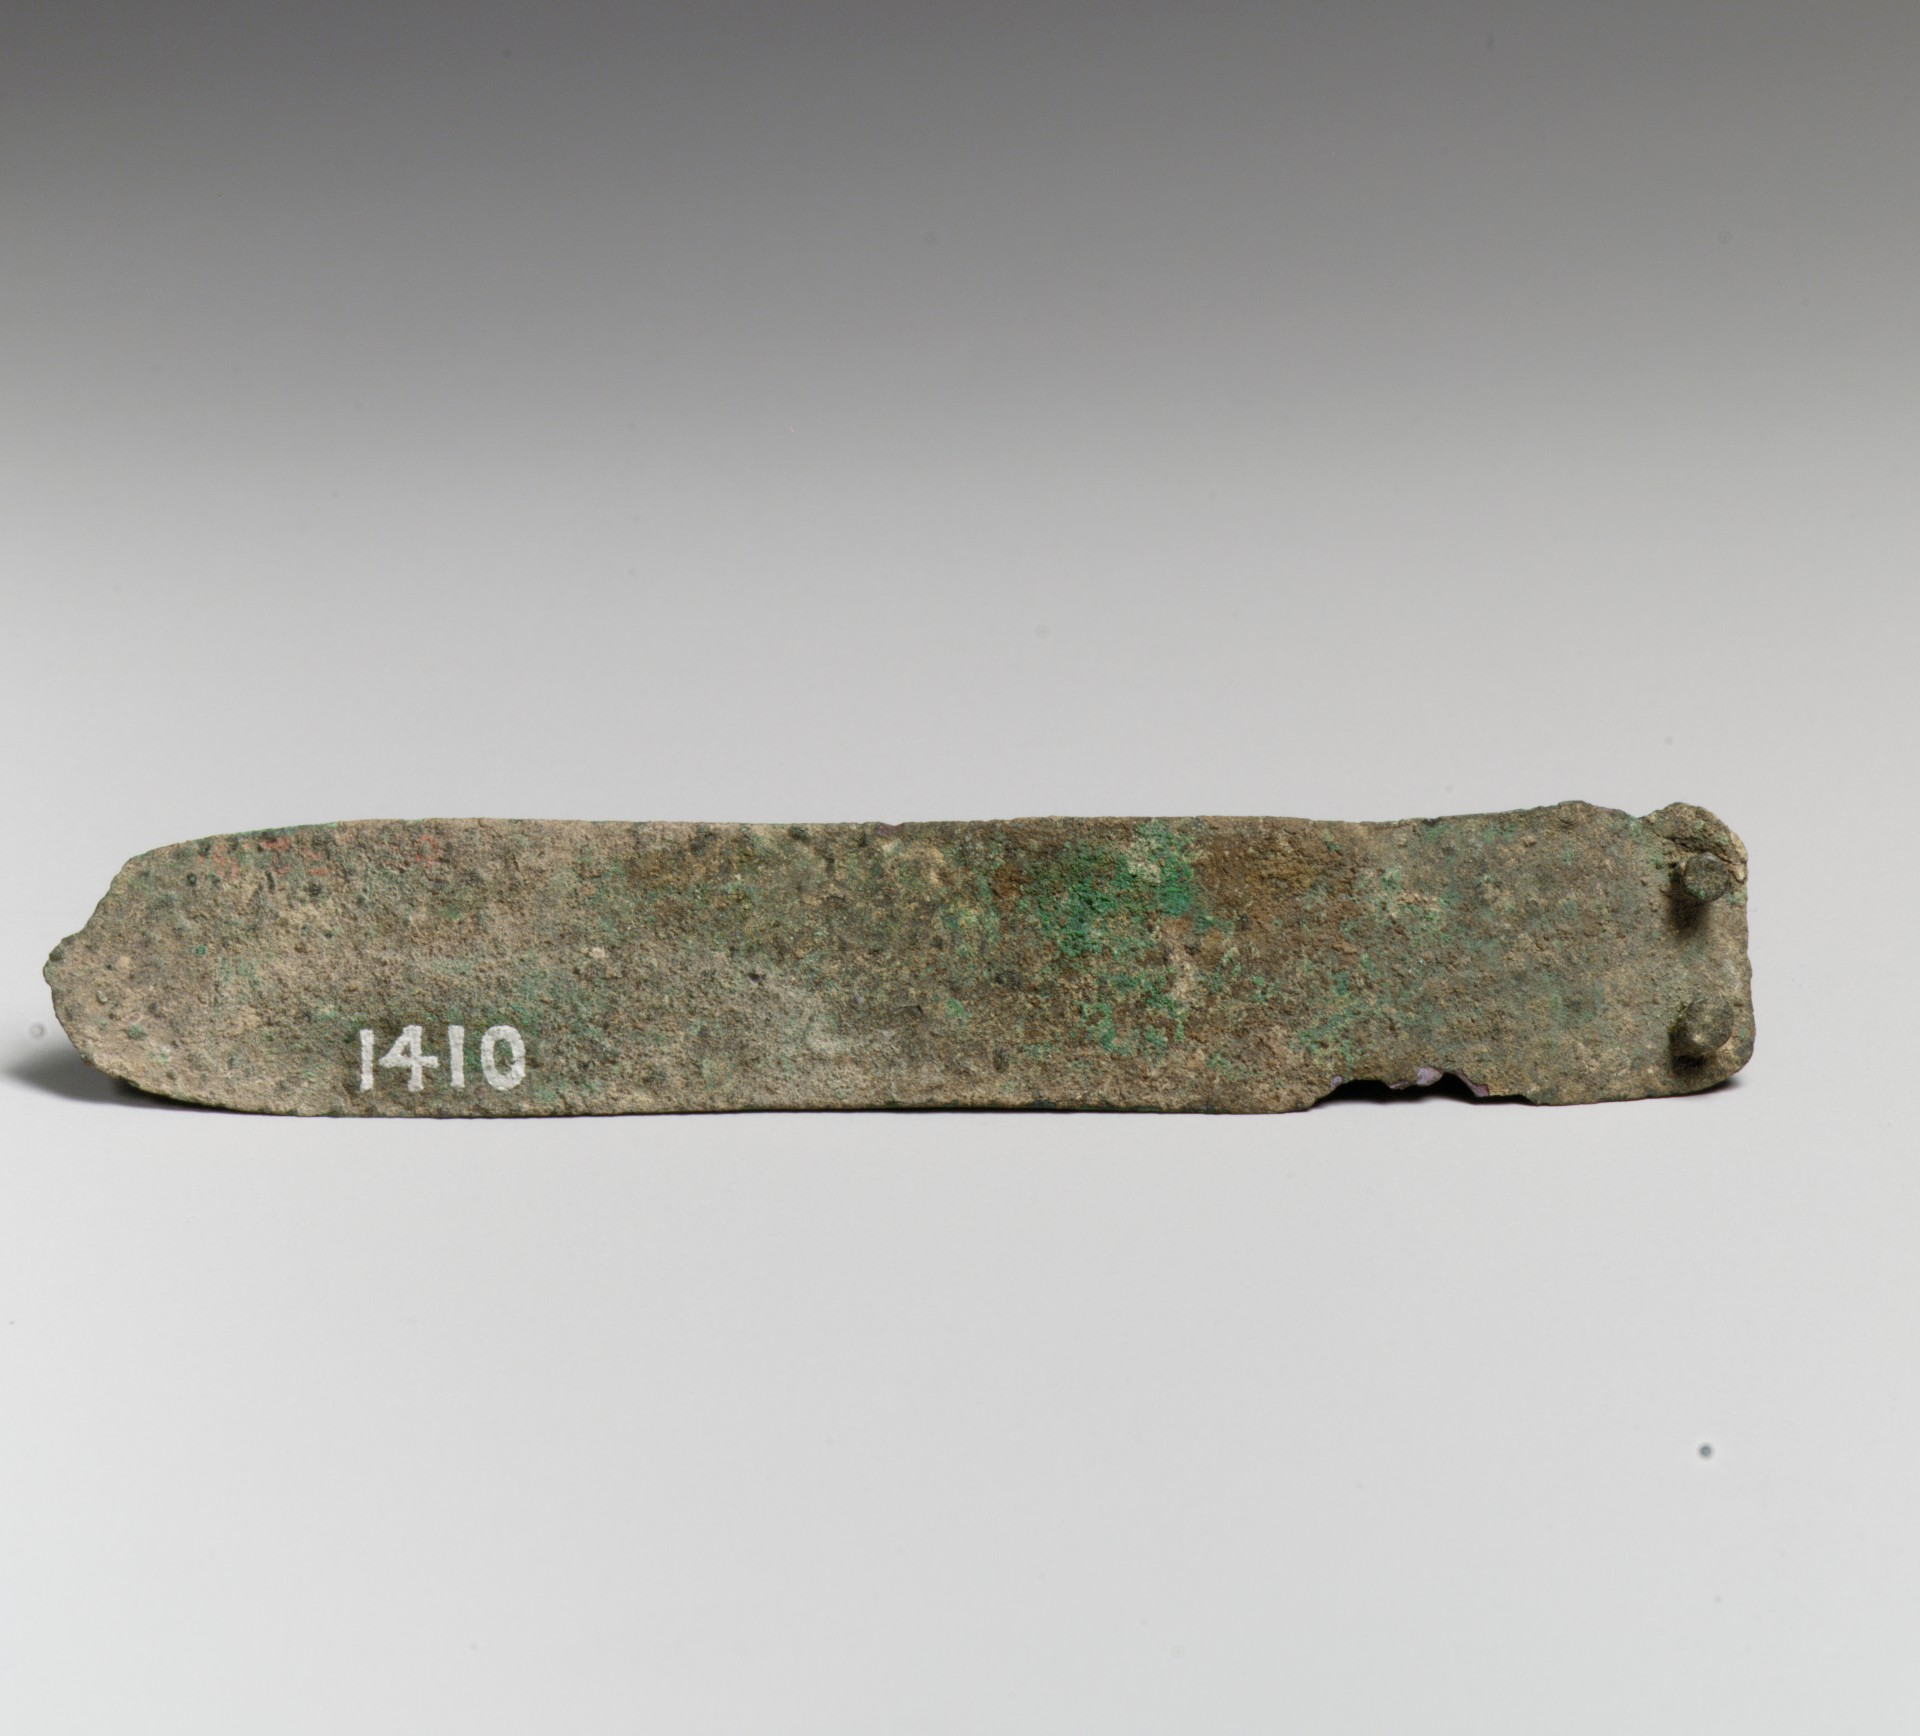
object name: knife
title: Bronze knife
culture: minoan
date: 1600-1050 BCE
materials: bronze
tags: knives